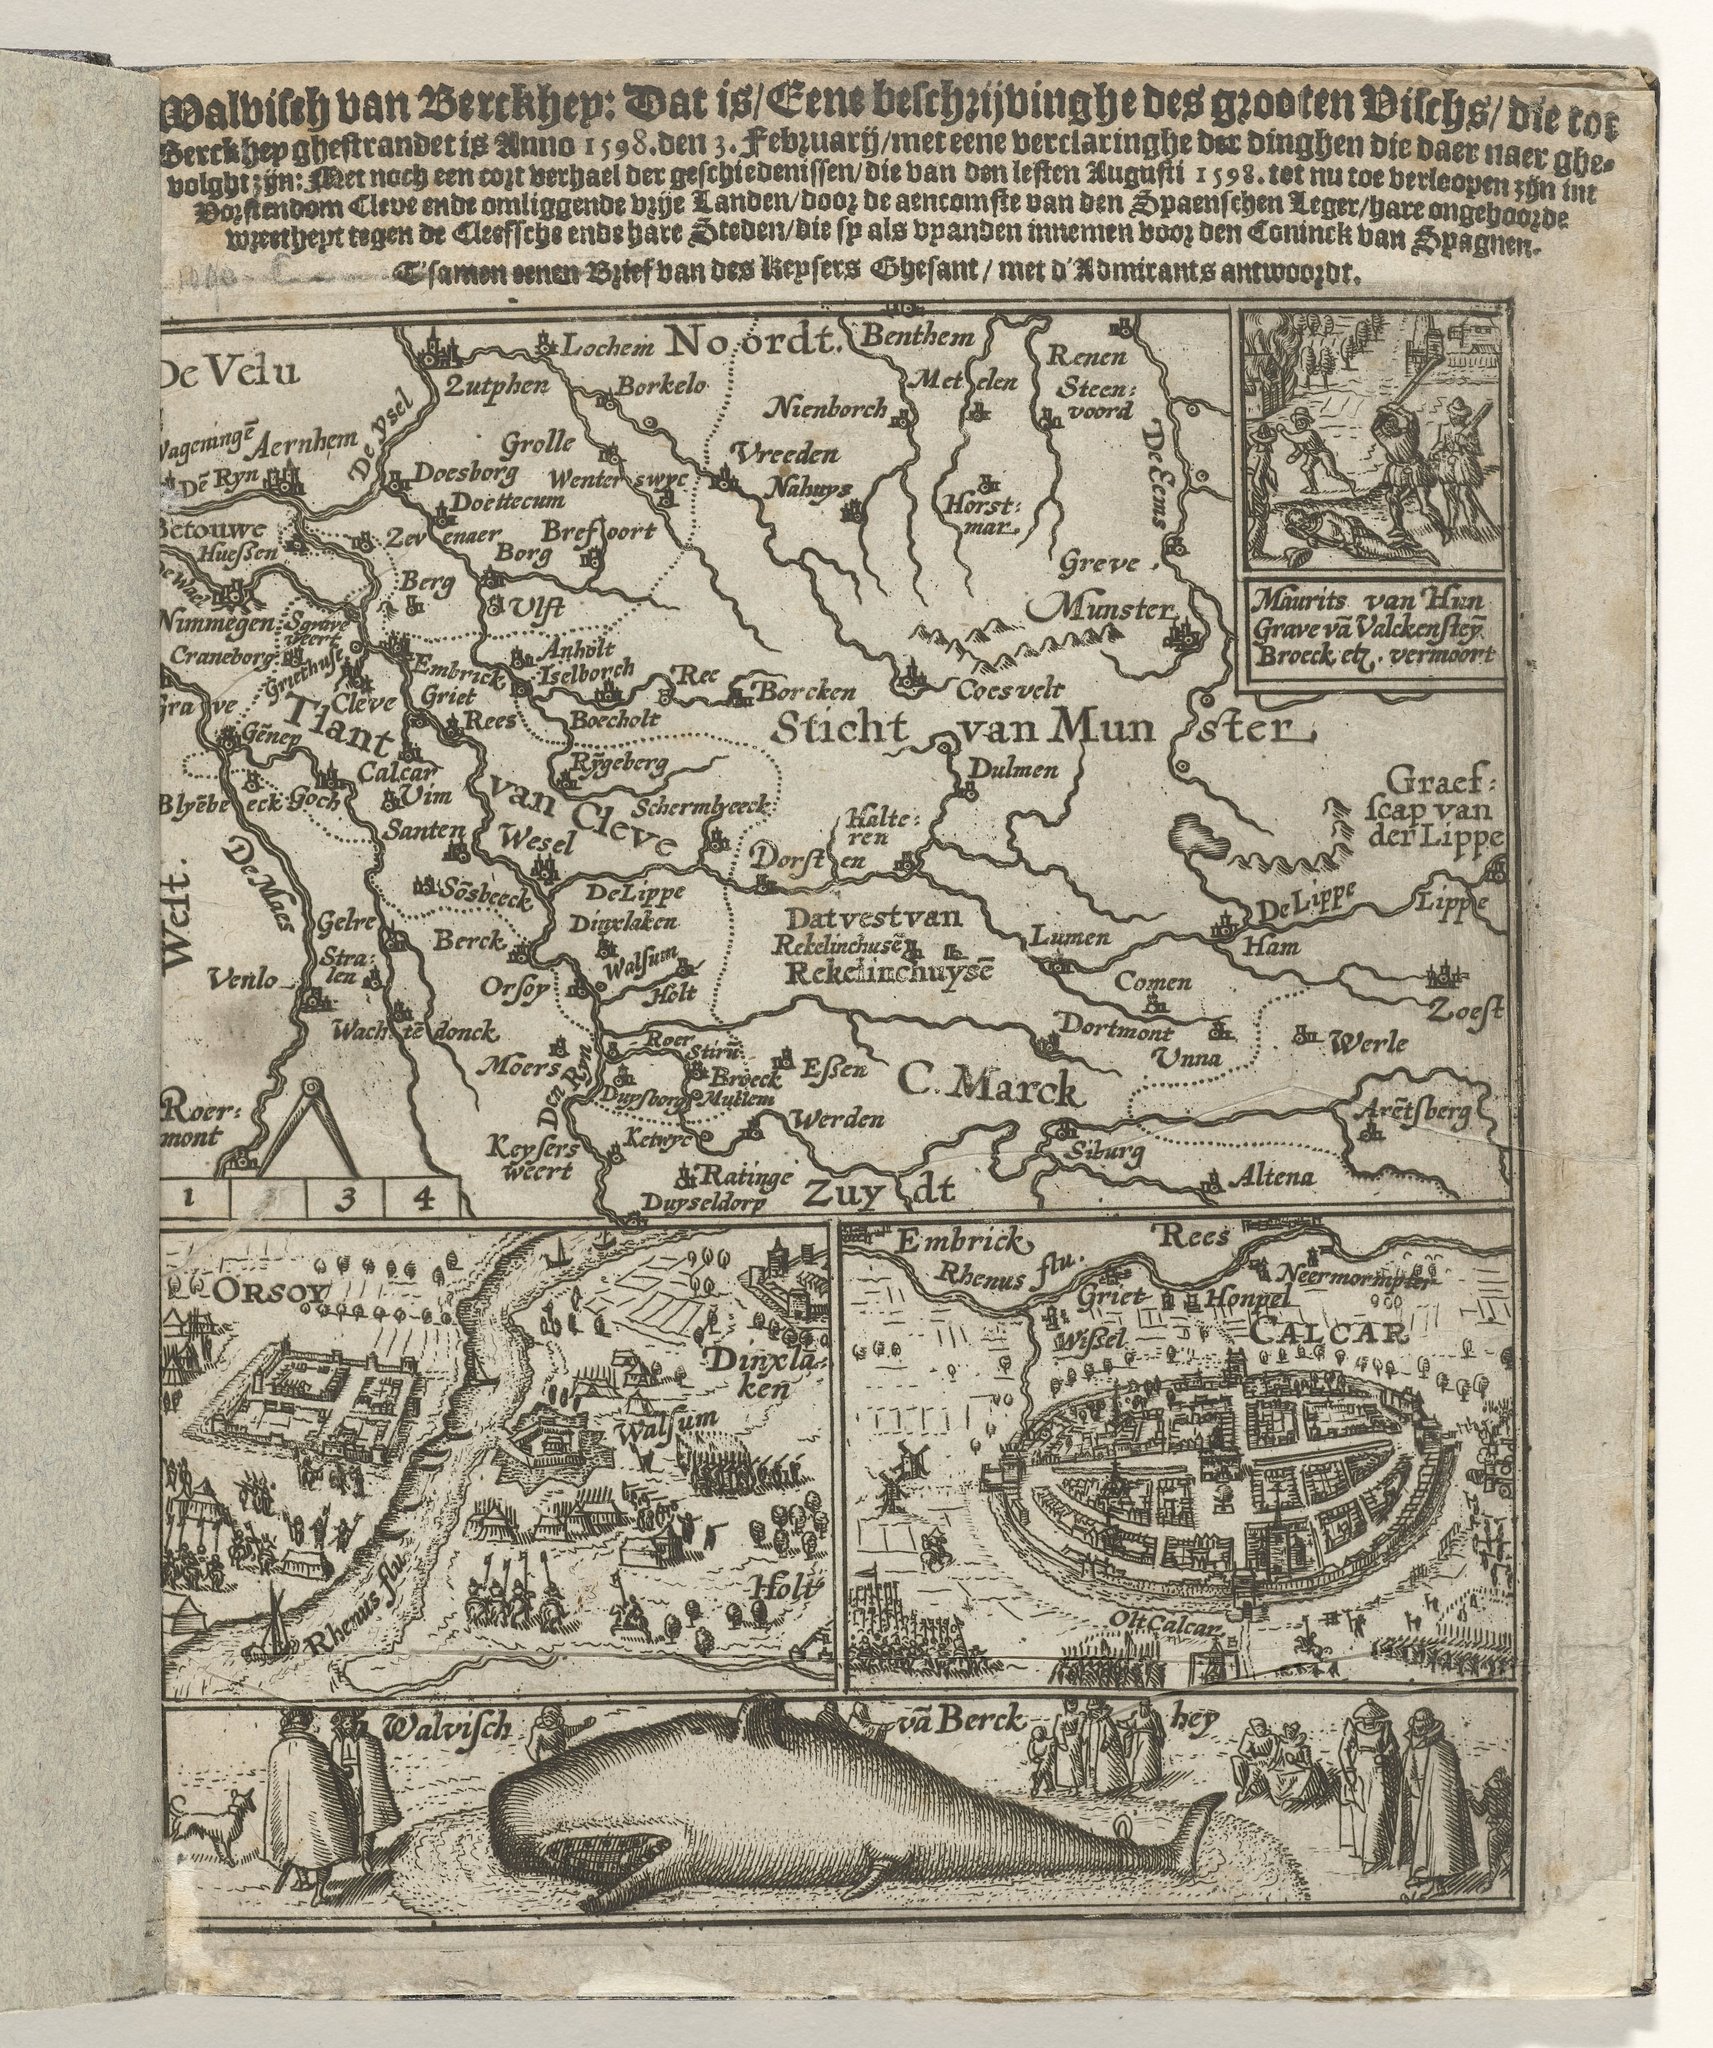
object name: titelblad, titelpagina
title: Titelpagina van het pamflet: Walvisch van Berckhey (...) ghestrandet is Anno 1598. den 3 Februarij, 1599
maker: Anonymous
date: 1590-1599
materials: paper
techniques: etching, letterpress printing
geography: low countries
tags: maps of separate countries or regions, swimming mammals: whale (+ dying animal; death of animal; dead animal), kalkar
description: Titelpagina van een pamflet over de oorlog in Westfalen en de walvis van Berckhey, 1598. Kaart van het oorlogstoneel in Gelderland, Kleef en Munster, de moord op de graaf van den Broeck, de strijd rond Orsoy en Kalkar en onderaan de walvis gestrand bij Berckhey tussen Katwijk en Scheveningen. Onderdeel van het pamflet getiteld: Walvisch van Berckhey : Dat is, Eene beschrijvinghe des grooten Vischs, die ... ghestrandet is Anno 1598. den 3 Februarij ... met noch een cort verhael der geschiedenissen die van den lesten Augusti 1598. tot nu toe verloopen zijn int Vorstendom Cleve... T'samen eenen Brief van des Keysers Ghesant, met d'Admirants antwoordt.